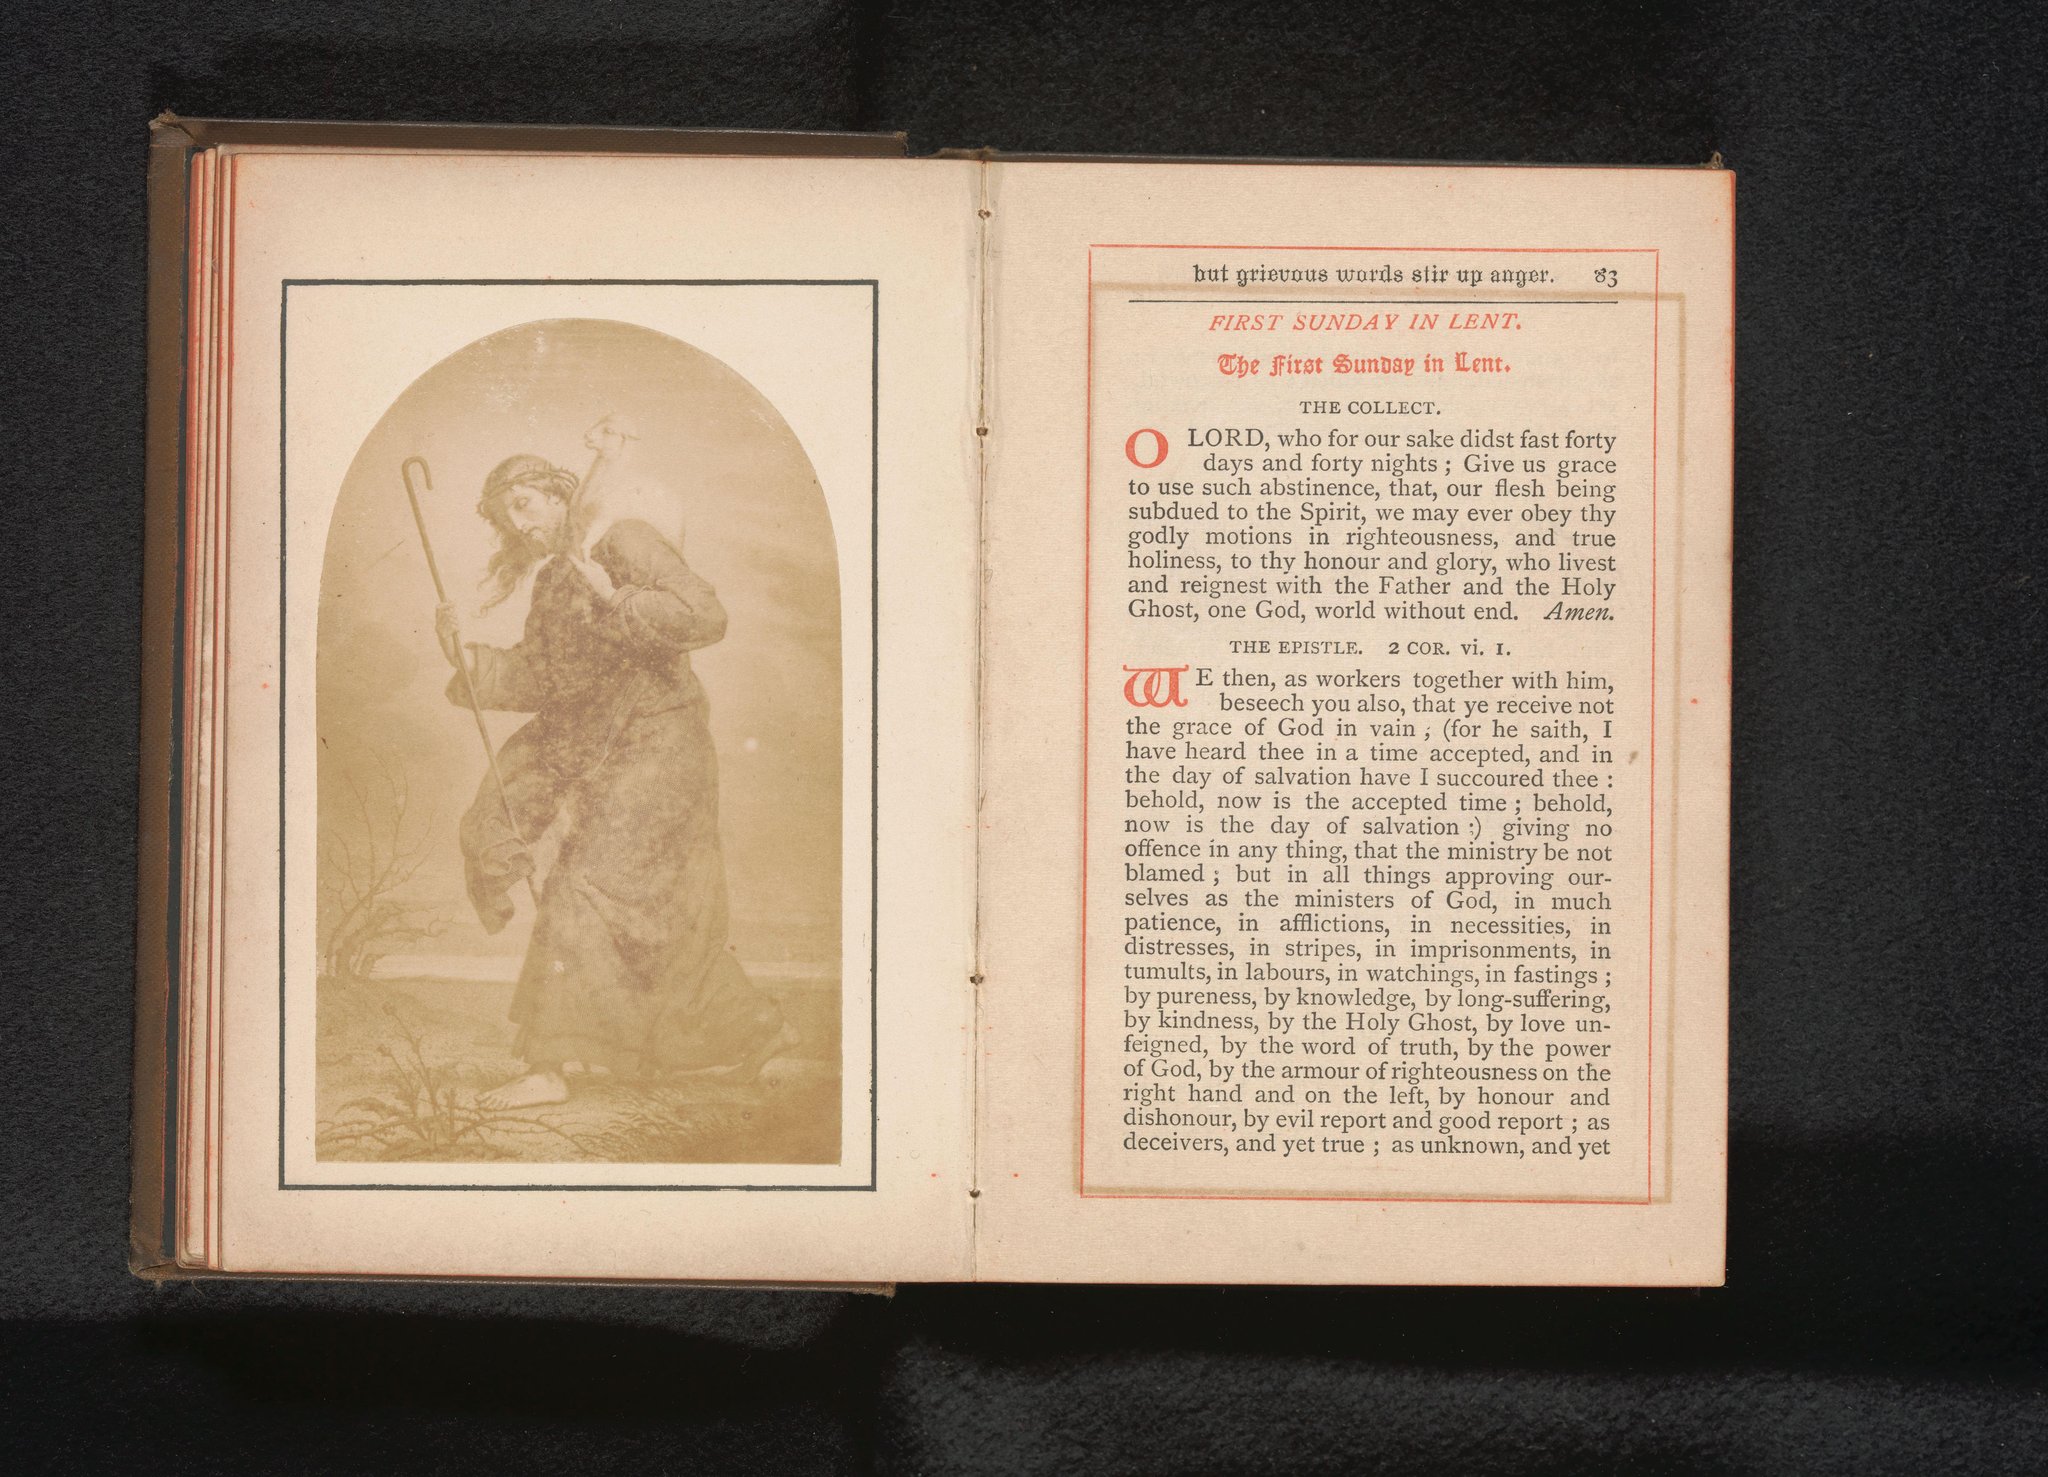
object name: photograph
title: Fotoreproductie van een schilderij, voorstellende Christus met een lam op de schouders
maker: Anonymous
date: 1870-1880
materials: photographic support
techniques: albumen print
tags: lamb bearing cross or banner, 'agnus dei' ~ symbol of christ, christ